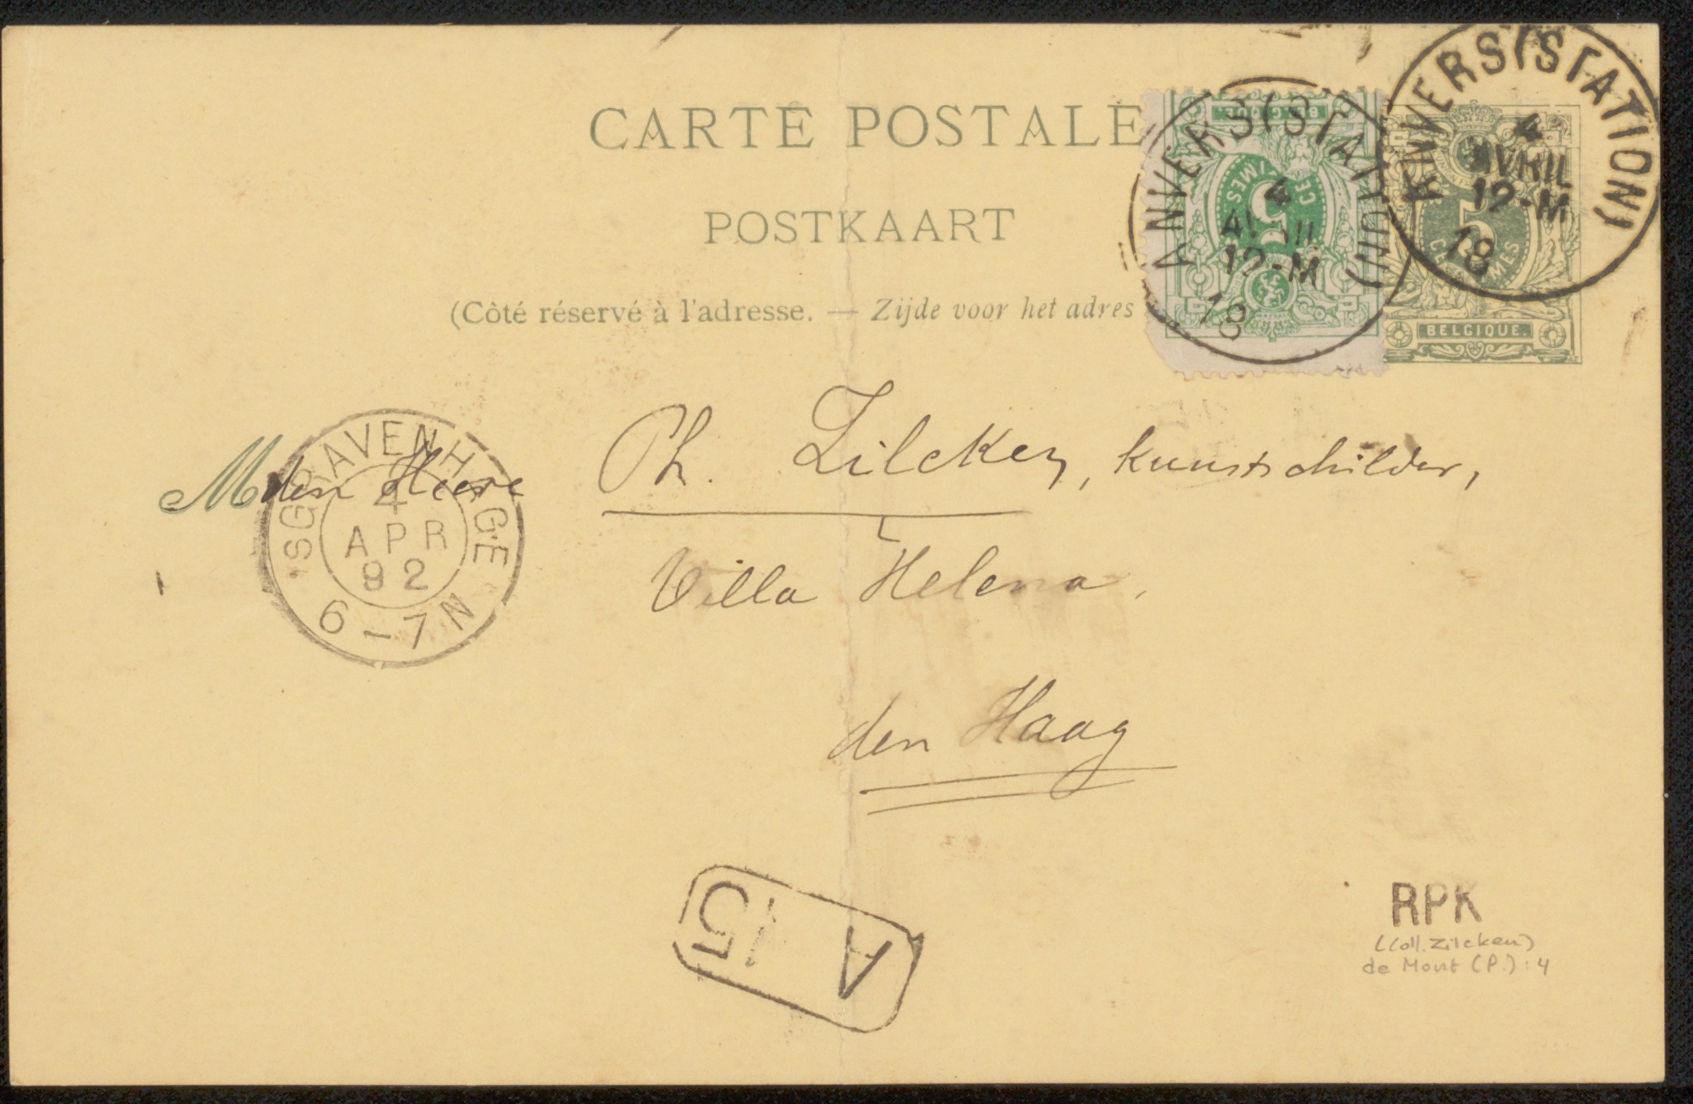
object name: postcard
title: Briefkaart aan Philip Zilcken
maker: pol de mont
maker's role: dichter, prozaschrijver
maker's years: 1857-1931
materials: cardboard, ink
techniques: pen, writing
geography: antwerp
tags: the hague, painter, print maker, draughtsman, jan toorop, philip zilcken, exhibition ~ art, antwerp, ghent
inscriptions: collector's mark: ‘RPK’